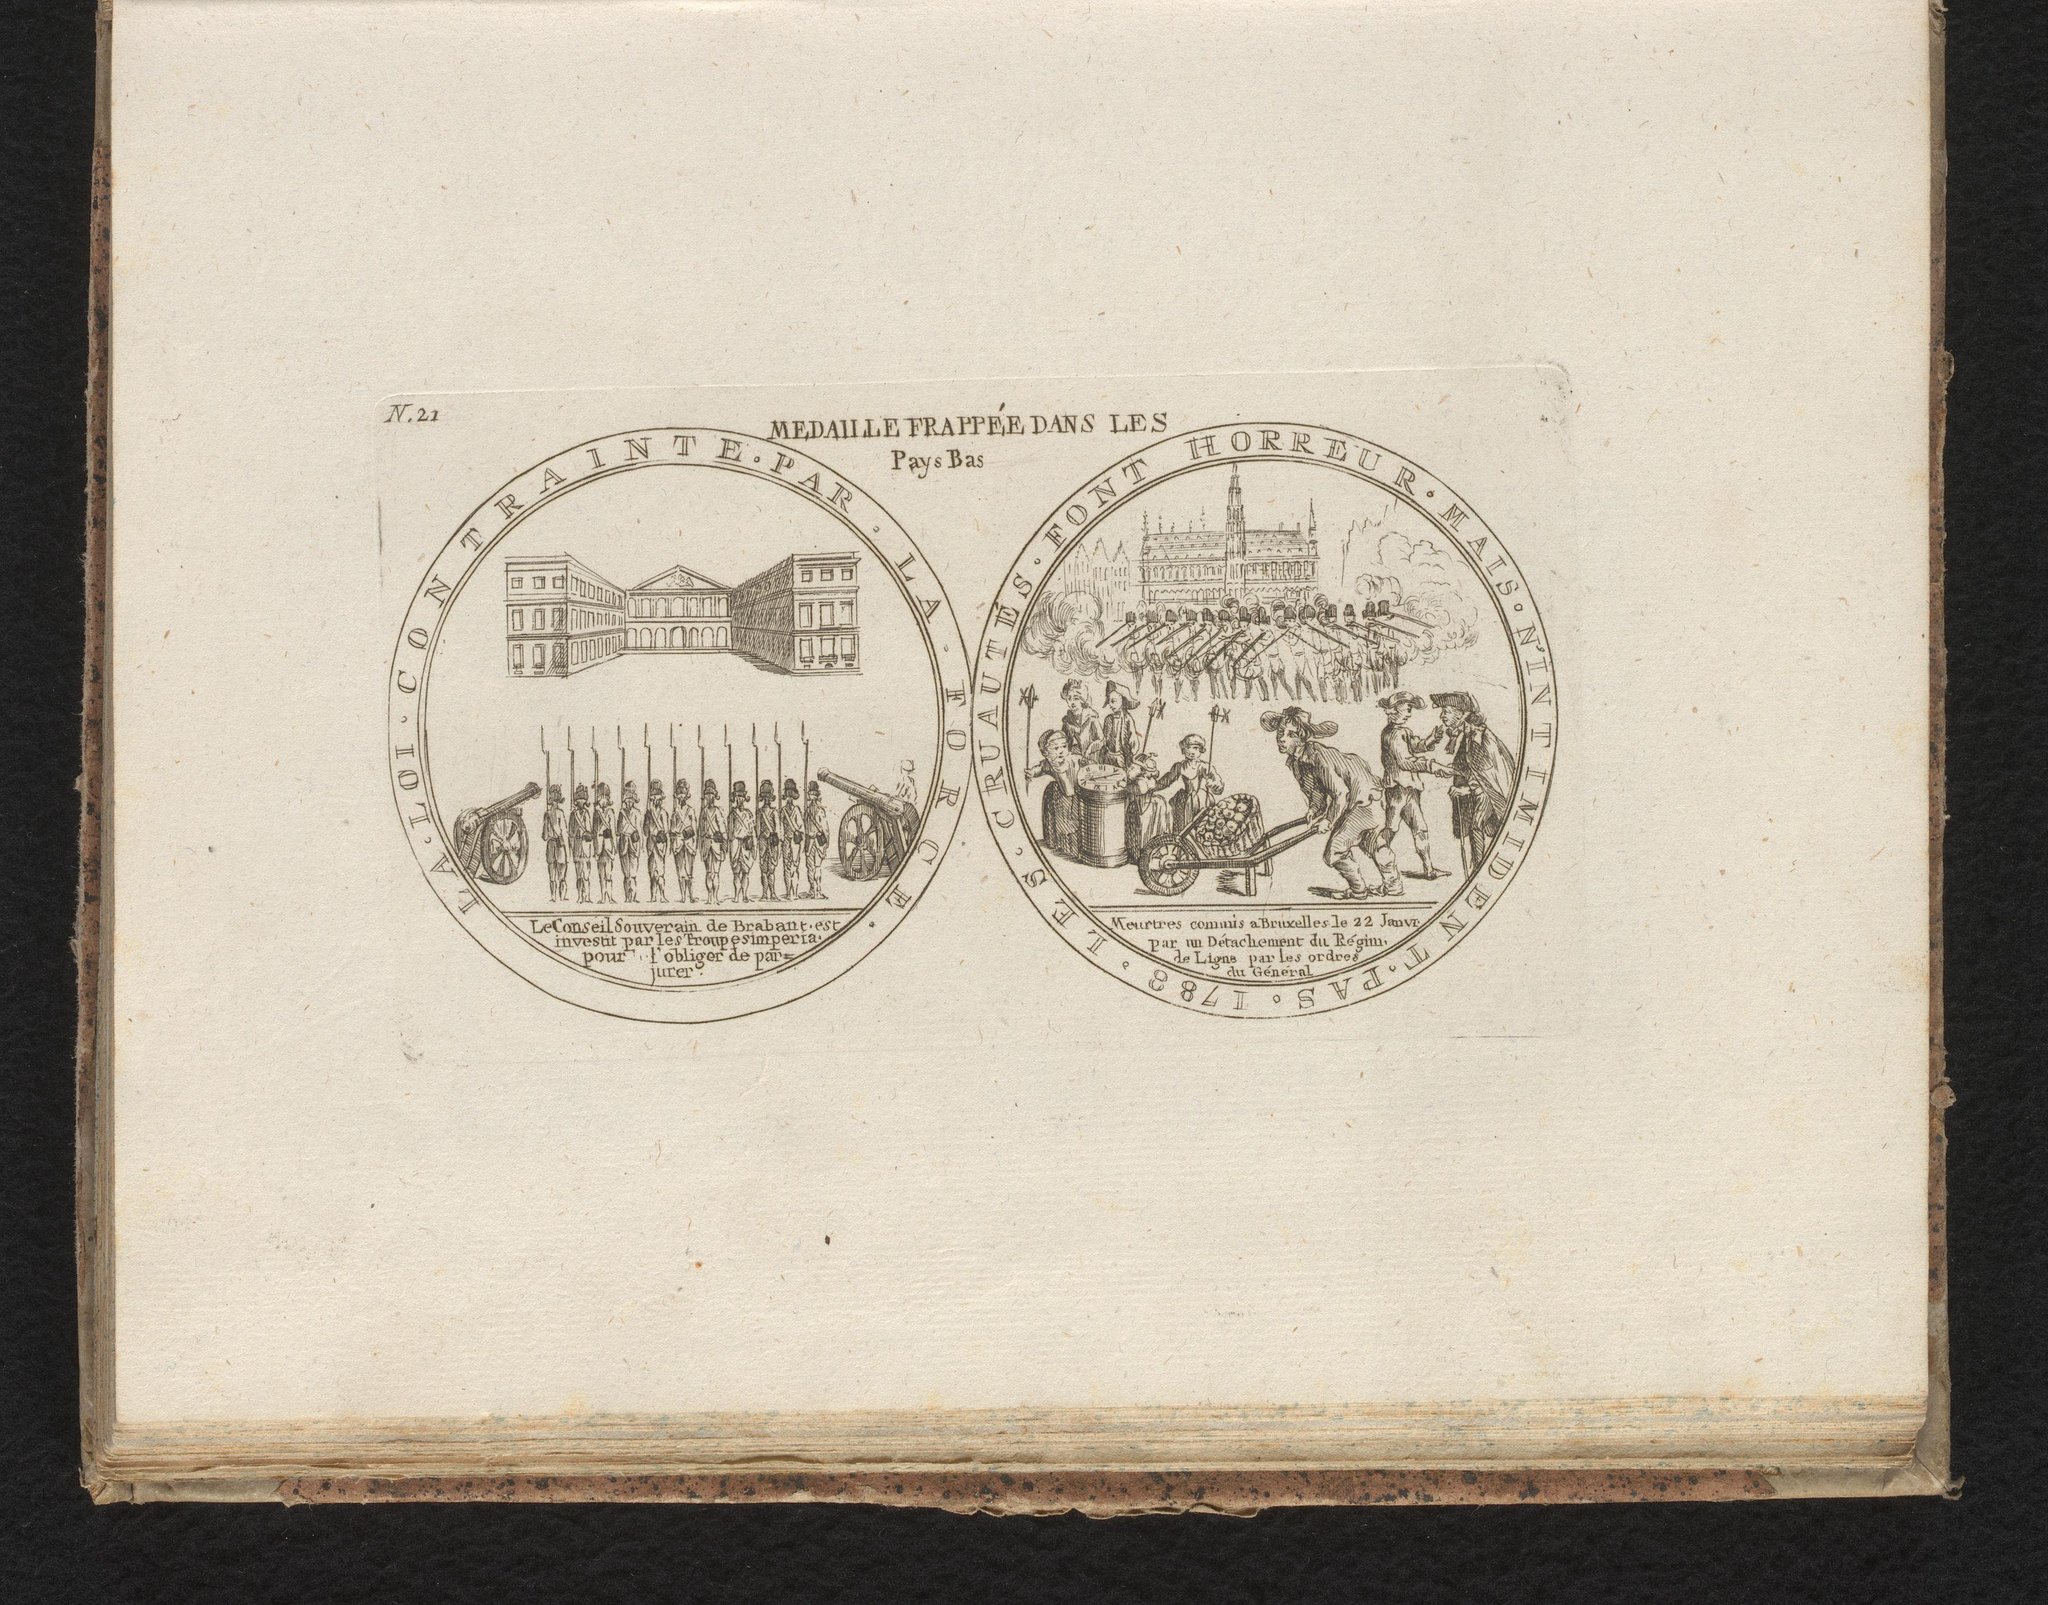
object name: print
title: Medaille frappée dans les Pays Bas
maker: Anonymous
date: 1787-1790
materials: paper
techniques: engraving, etching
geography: southern netherlands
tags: medal (considered as a piece of sculpture, regardless of its specific function), brabant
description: Penning ter ere van de slachtoffers gevallen in Brussel op 22 januari 1788. Op de voorzijde een bataljon soldaten voor het gebouw waar de Staten van Brabant vergaderen; keerzijde: Oostenrijkse soldaten vuren op onschuldige burgers op de Grote Markt te Brussel, 22 januari 1788. Genummerd linksboven: N. 21. Onderdeel van de gebundelde verzameling prenten betrekking hebbend op de gebeurtenissen van de Brabantse Omwenteling en de periode 1787-1790.